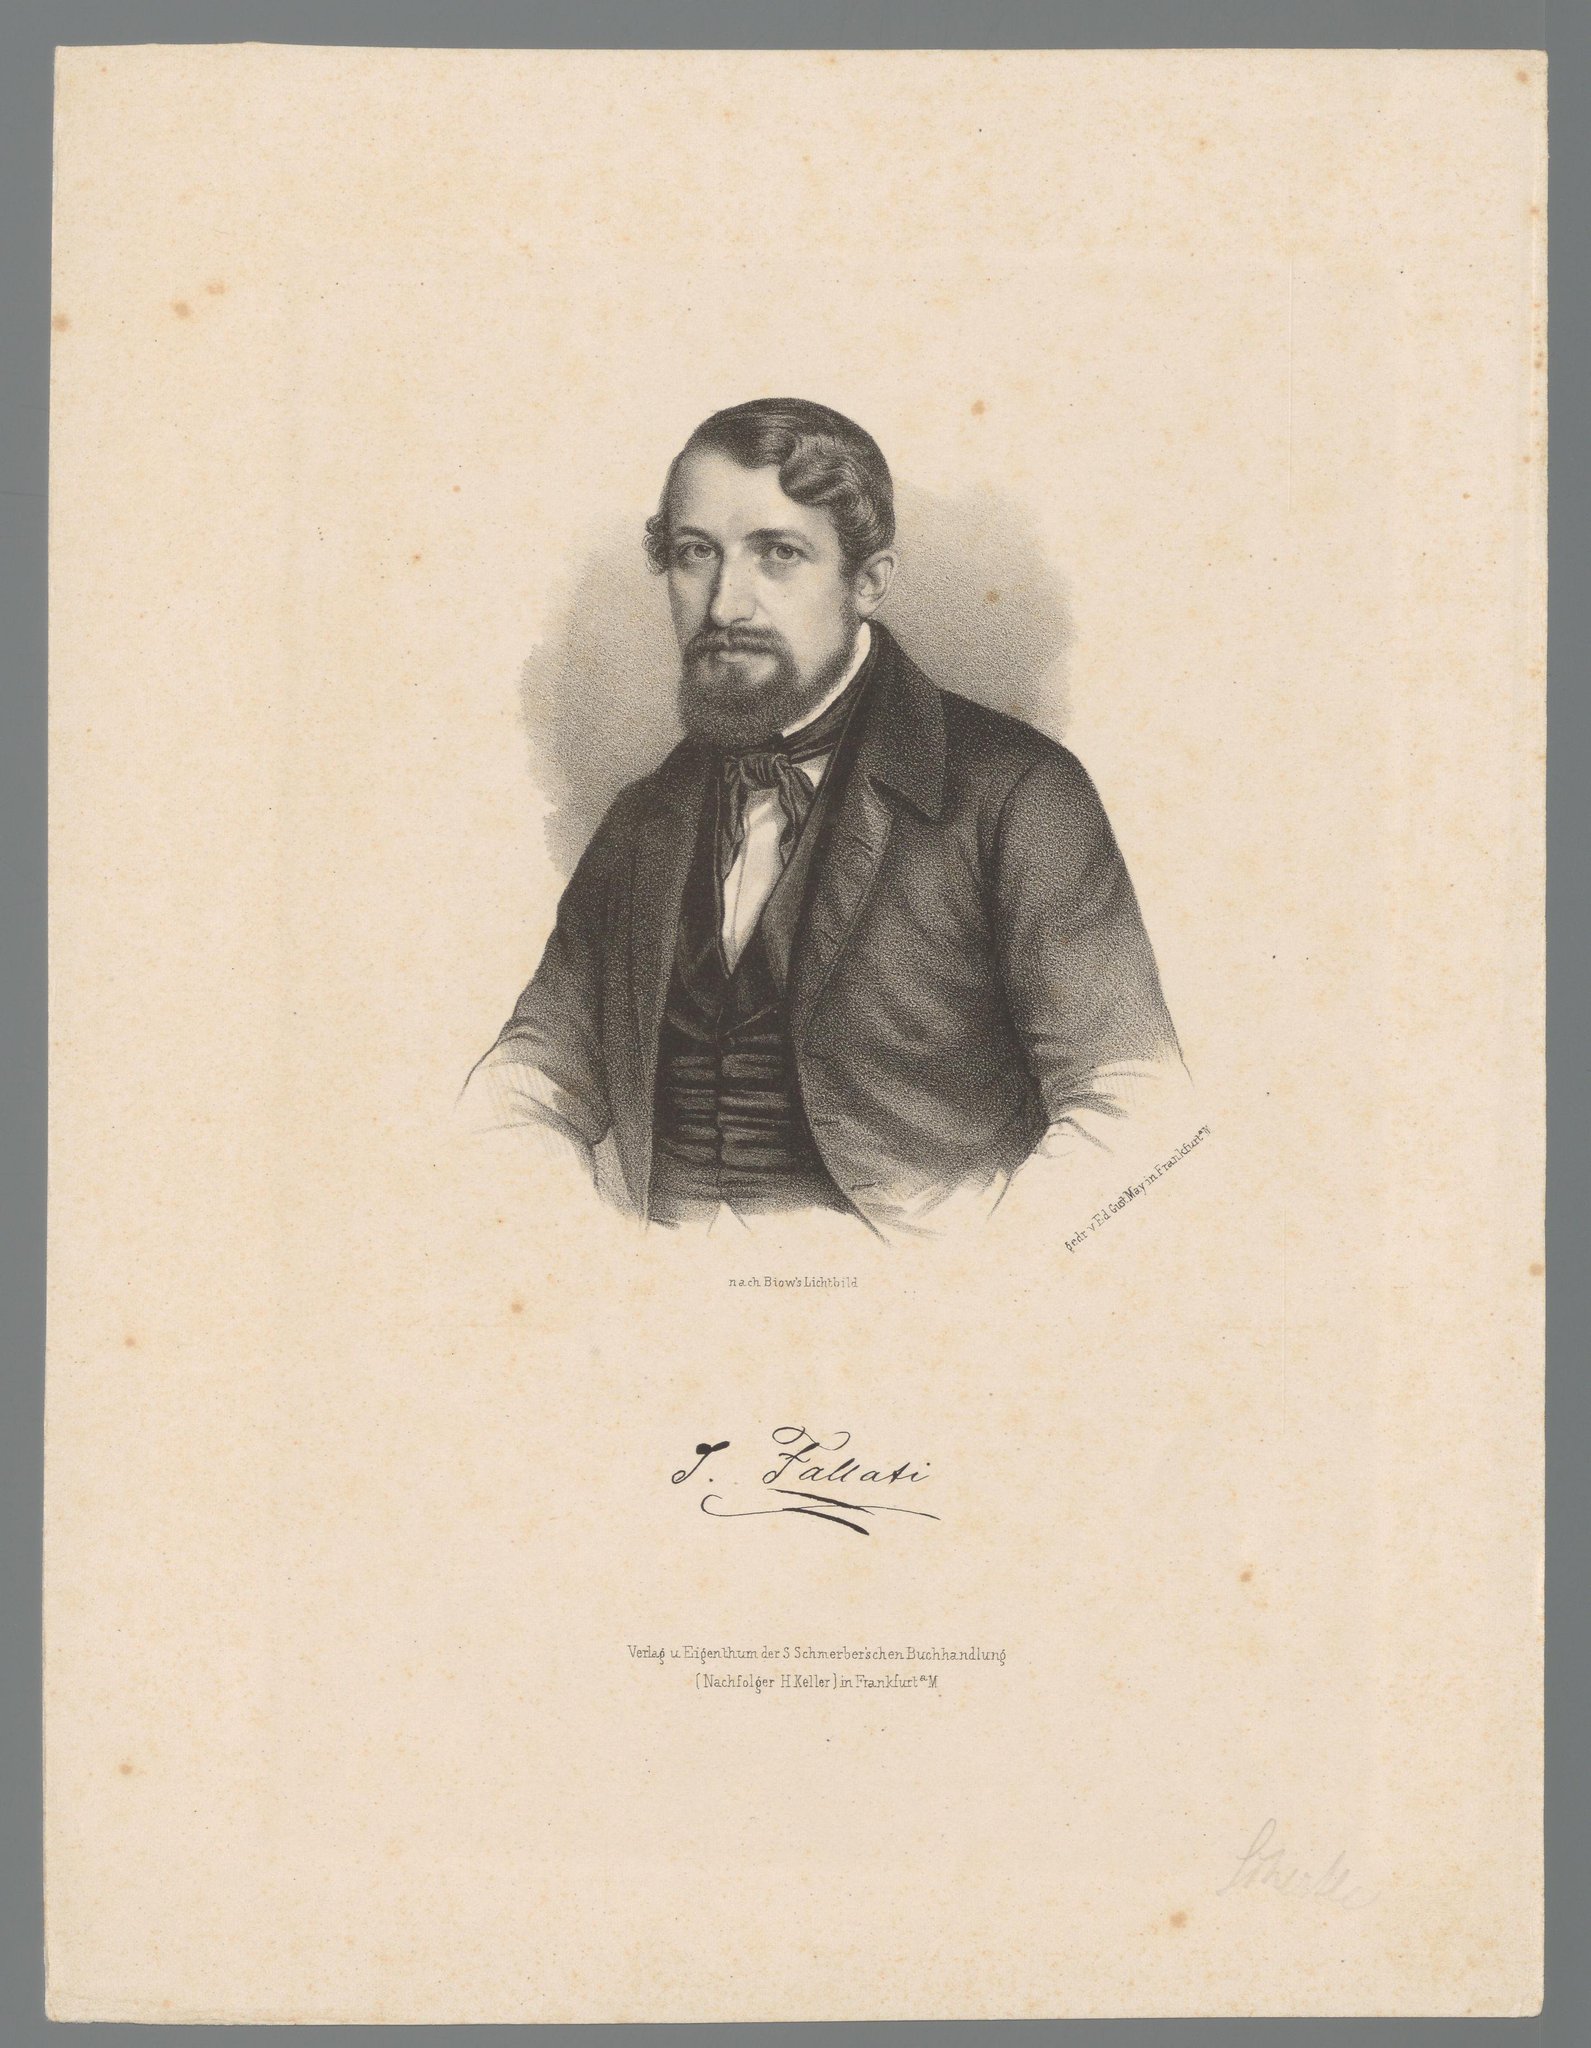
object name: print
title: Die Männer des deutschen Volks, besonders nach Biows Lichtbildern auf Stein gezeichnet von Schertle und Hickmann, oder Deutsche National-Gallerie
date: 1848-1849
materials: paper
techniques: lithograph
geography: frankfurt am main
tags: adult man, historical persons, beard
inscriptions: collector's mark: Lugt 2228